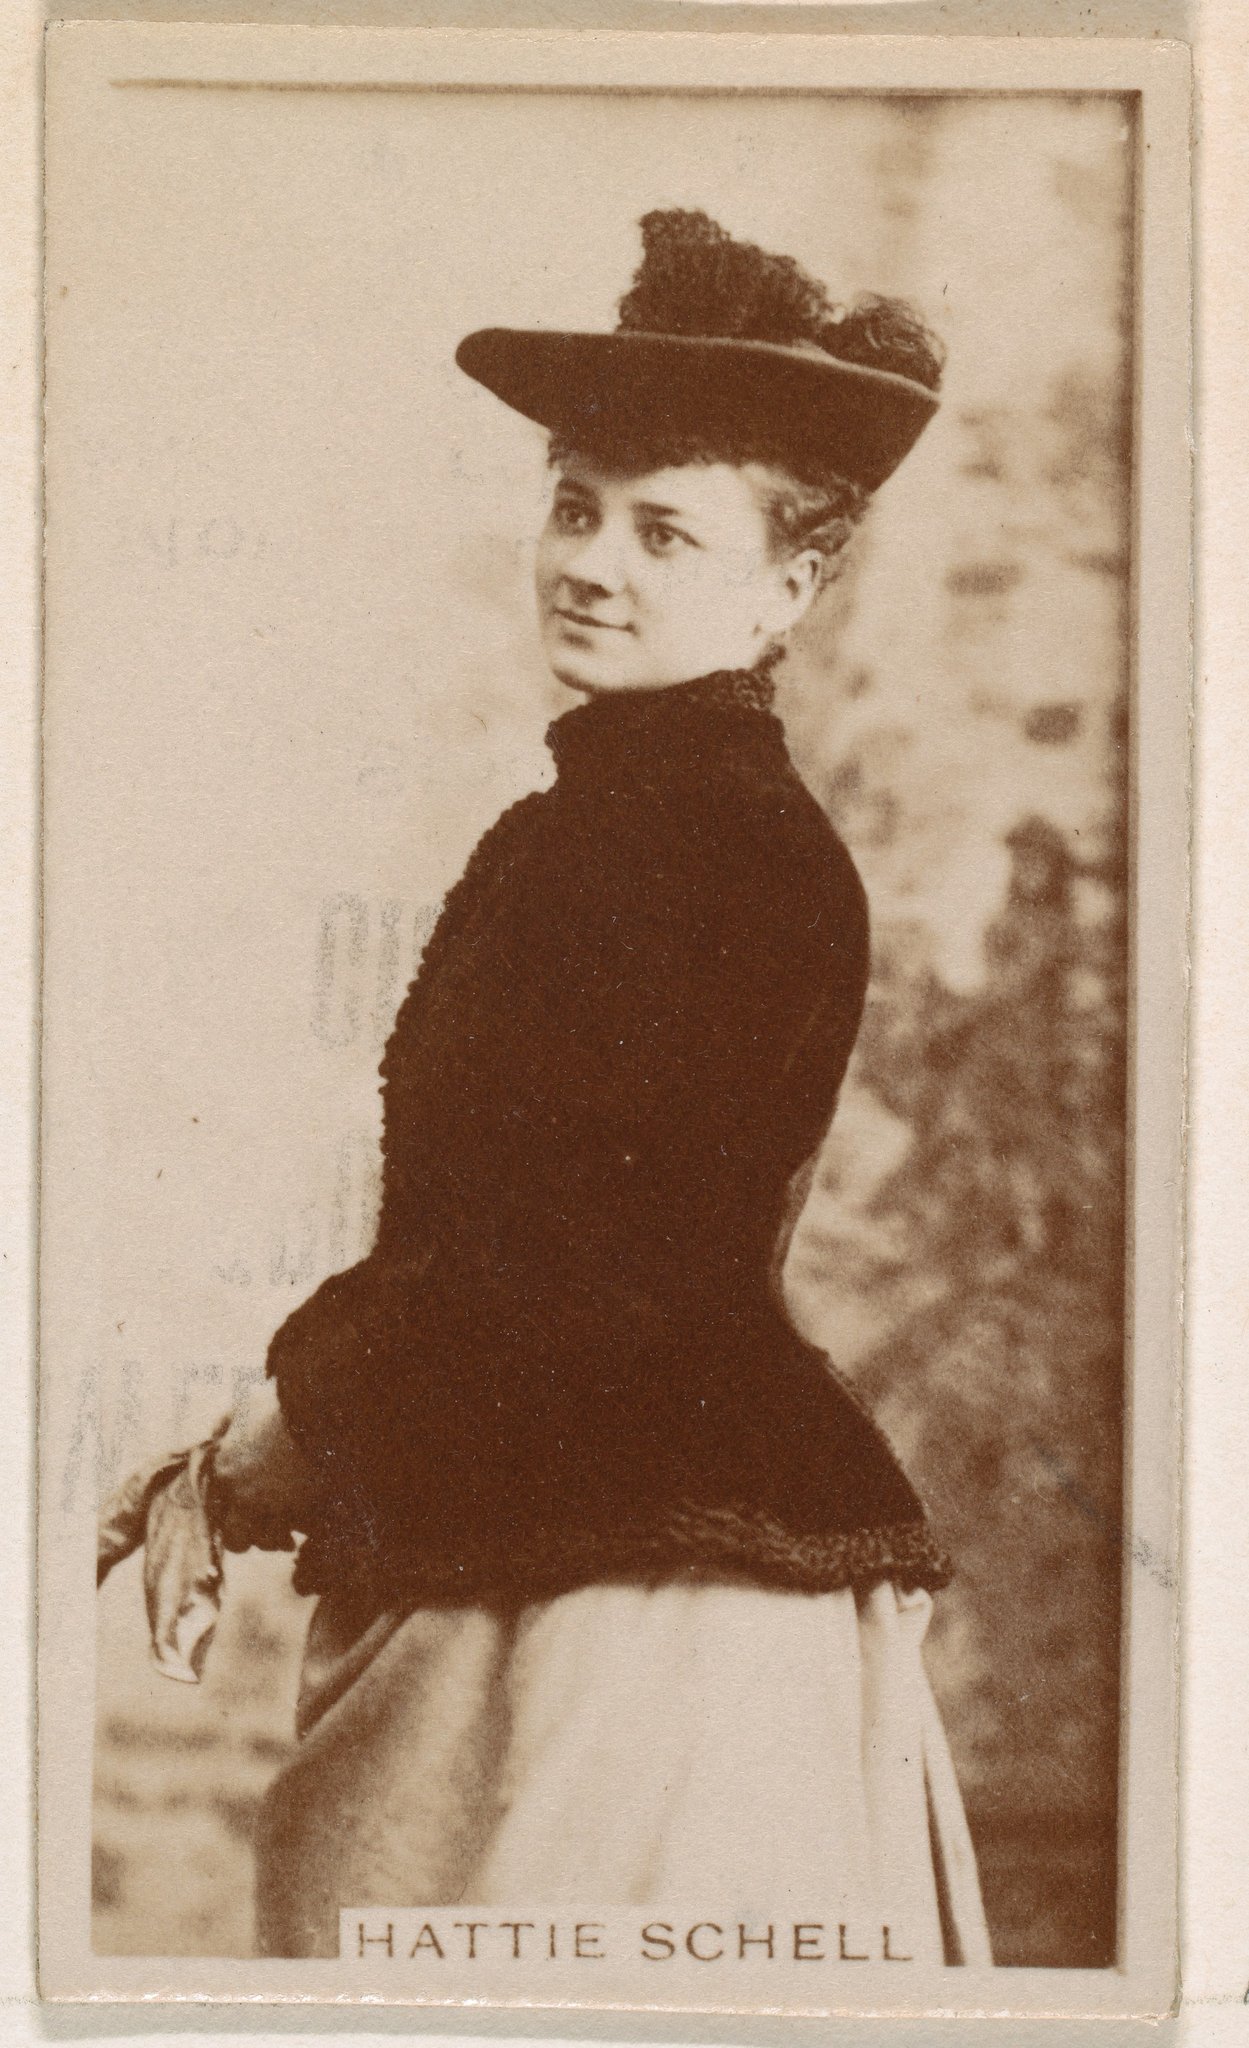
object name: photograph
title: Hattie Schell, from the Actresses series (N245) issued by Kinney Brothers to promote Sweet Caporal Cigarettes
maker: kinney brothers tobacco company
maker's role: publisher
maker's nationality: american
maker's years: 1869-2011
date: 1890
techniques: albumen silver print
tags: portraits,women,actresses